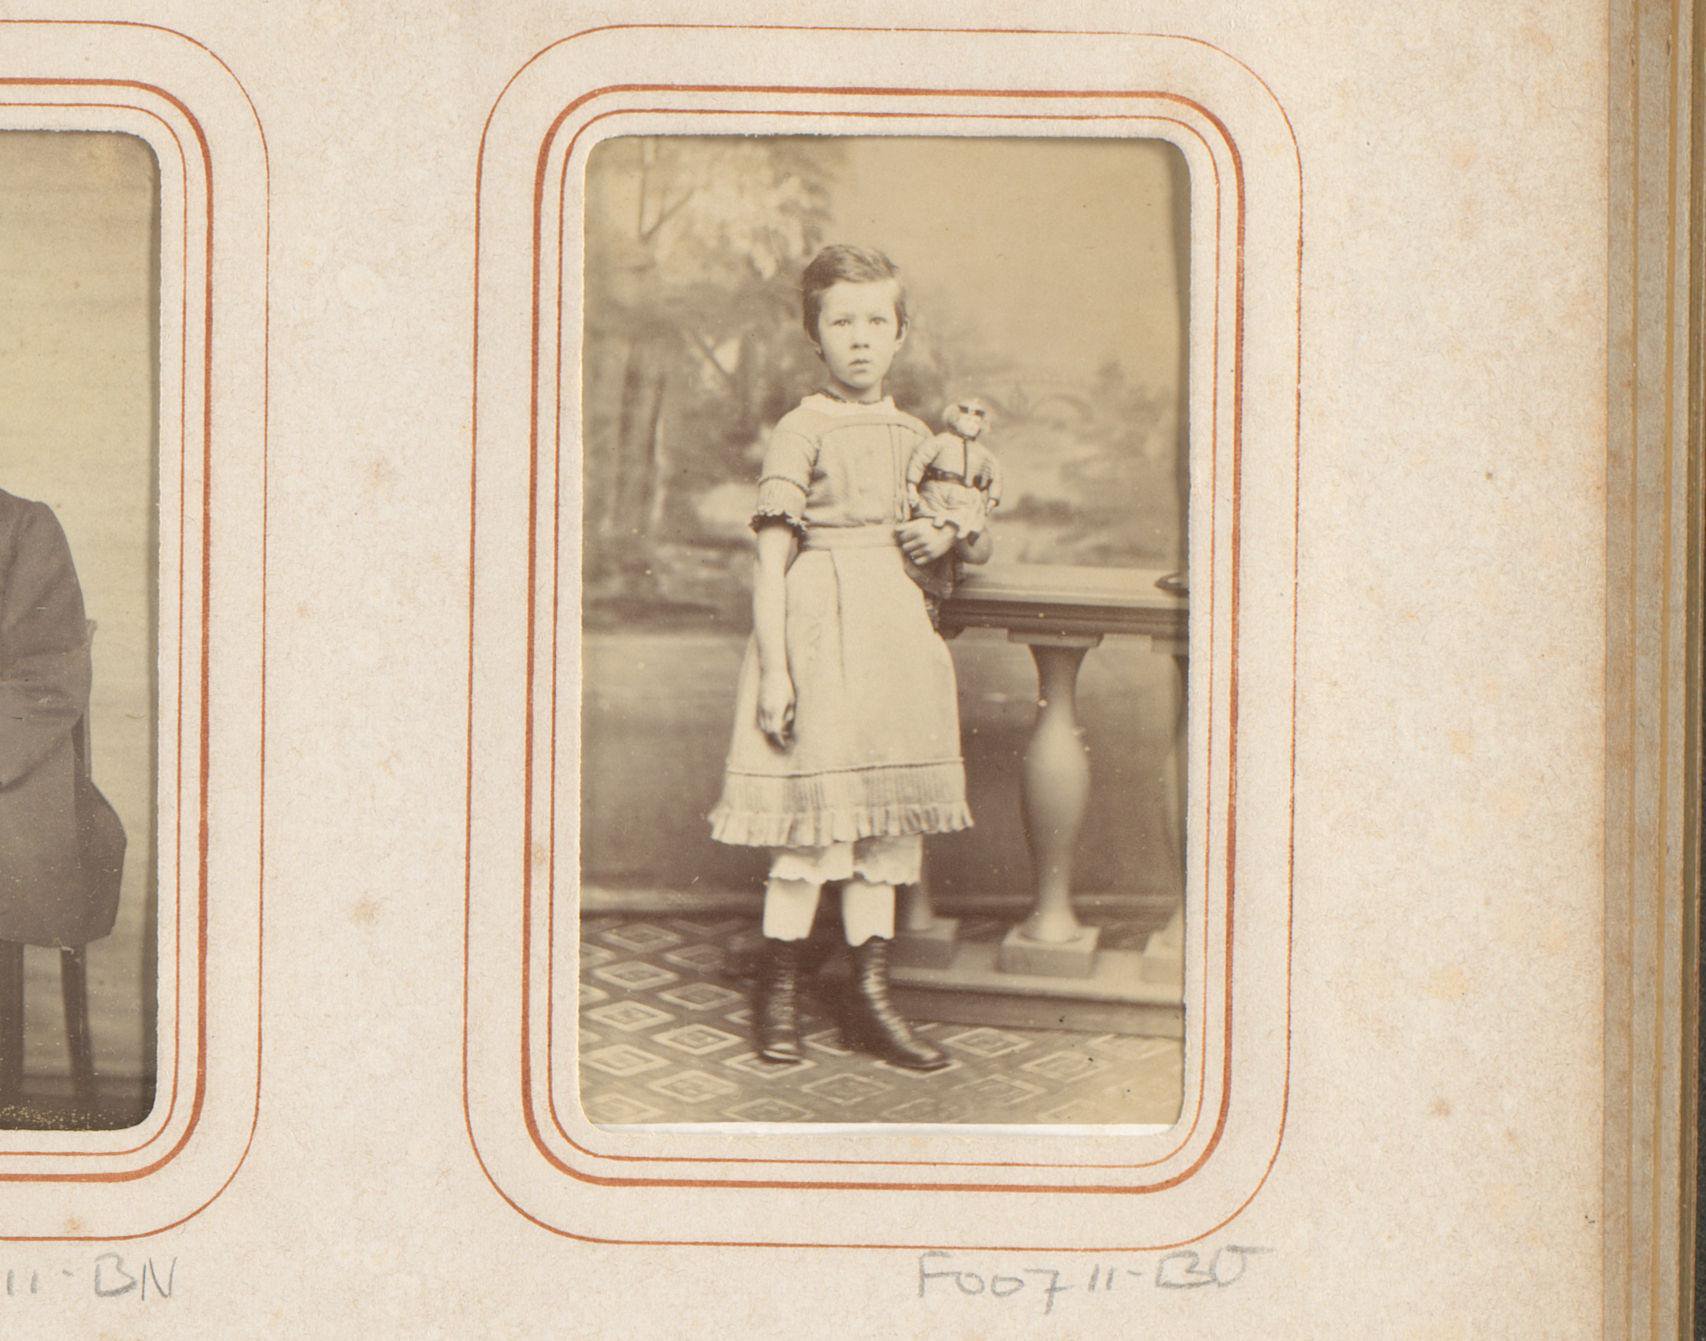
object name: photograph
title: Portret van een meisje met pop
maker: kornelis willem schorteldoek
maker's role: boekbinder, fotograaf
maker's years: 1800-1885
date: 1860-1885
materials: cardboard, photographic support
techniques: albumen print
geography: gorinchem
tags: girl (child between toddler and youth), (playing with) dolls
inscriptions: inscription: ‘Schorteldoek/ Photograaf/ Gorinchem/ Groote Markt’